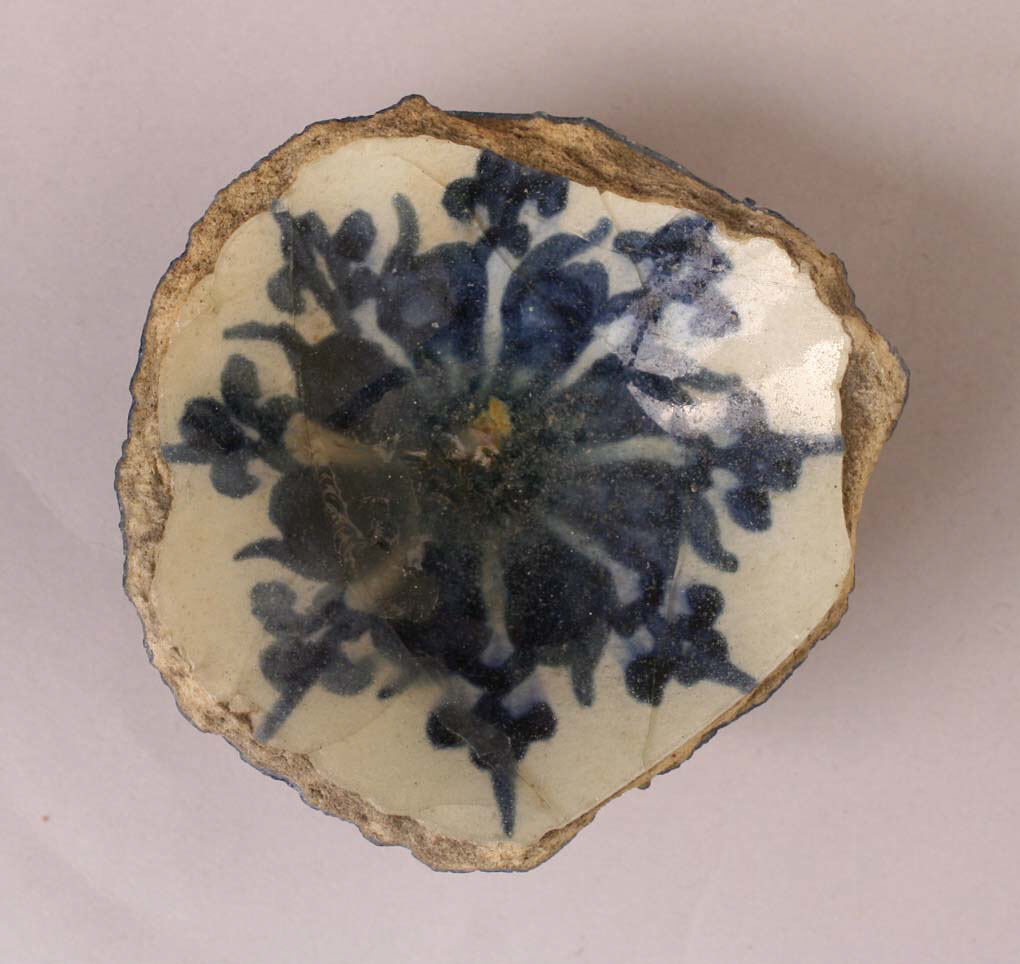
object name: fragment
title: Fragment of a Bowl or Cup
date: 1201-1600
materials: glaze, stonepaste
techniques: painting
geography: egypt